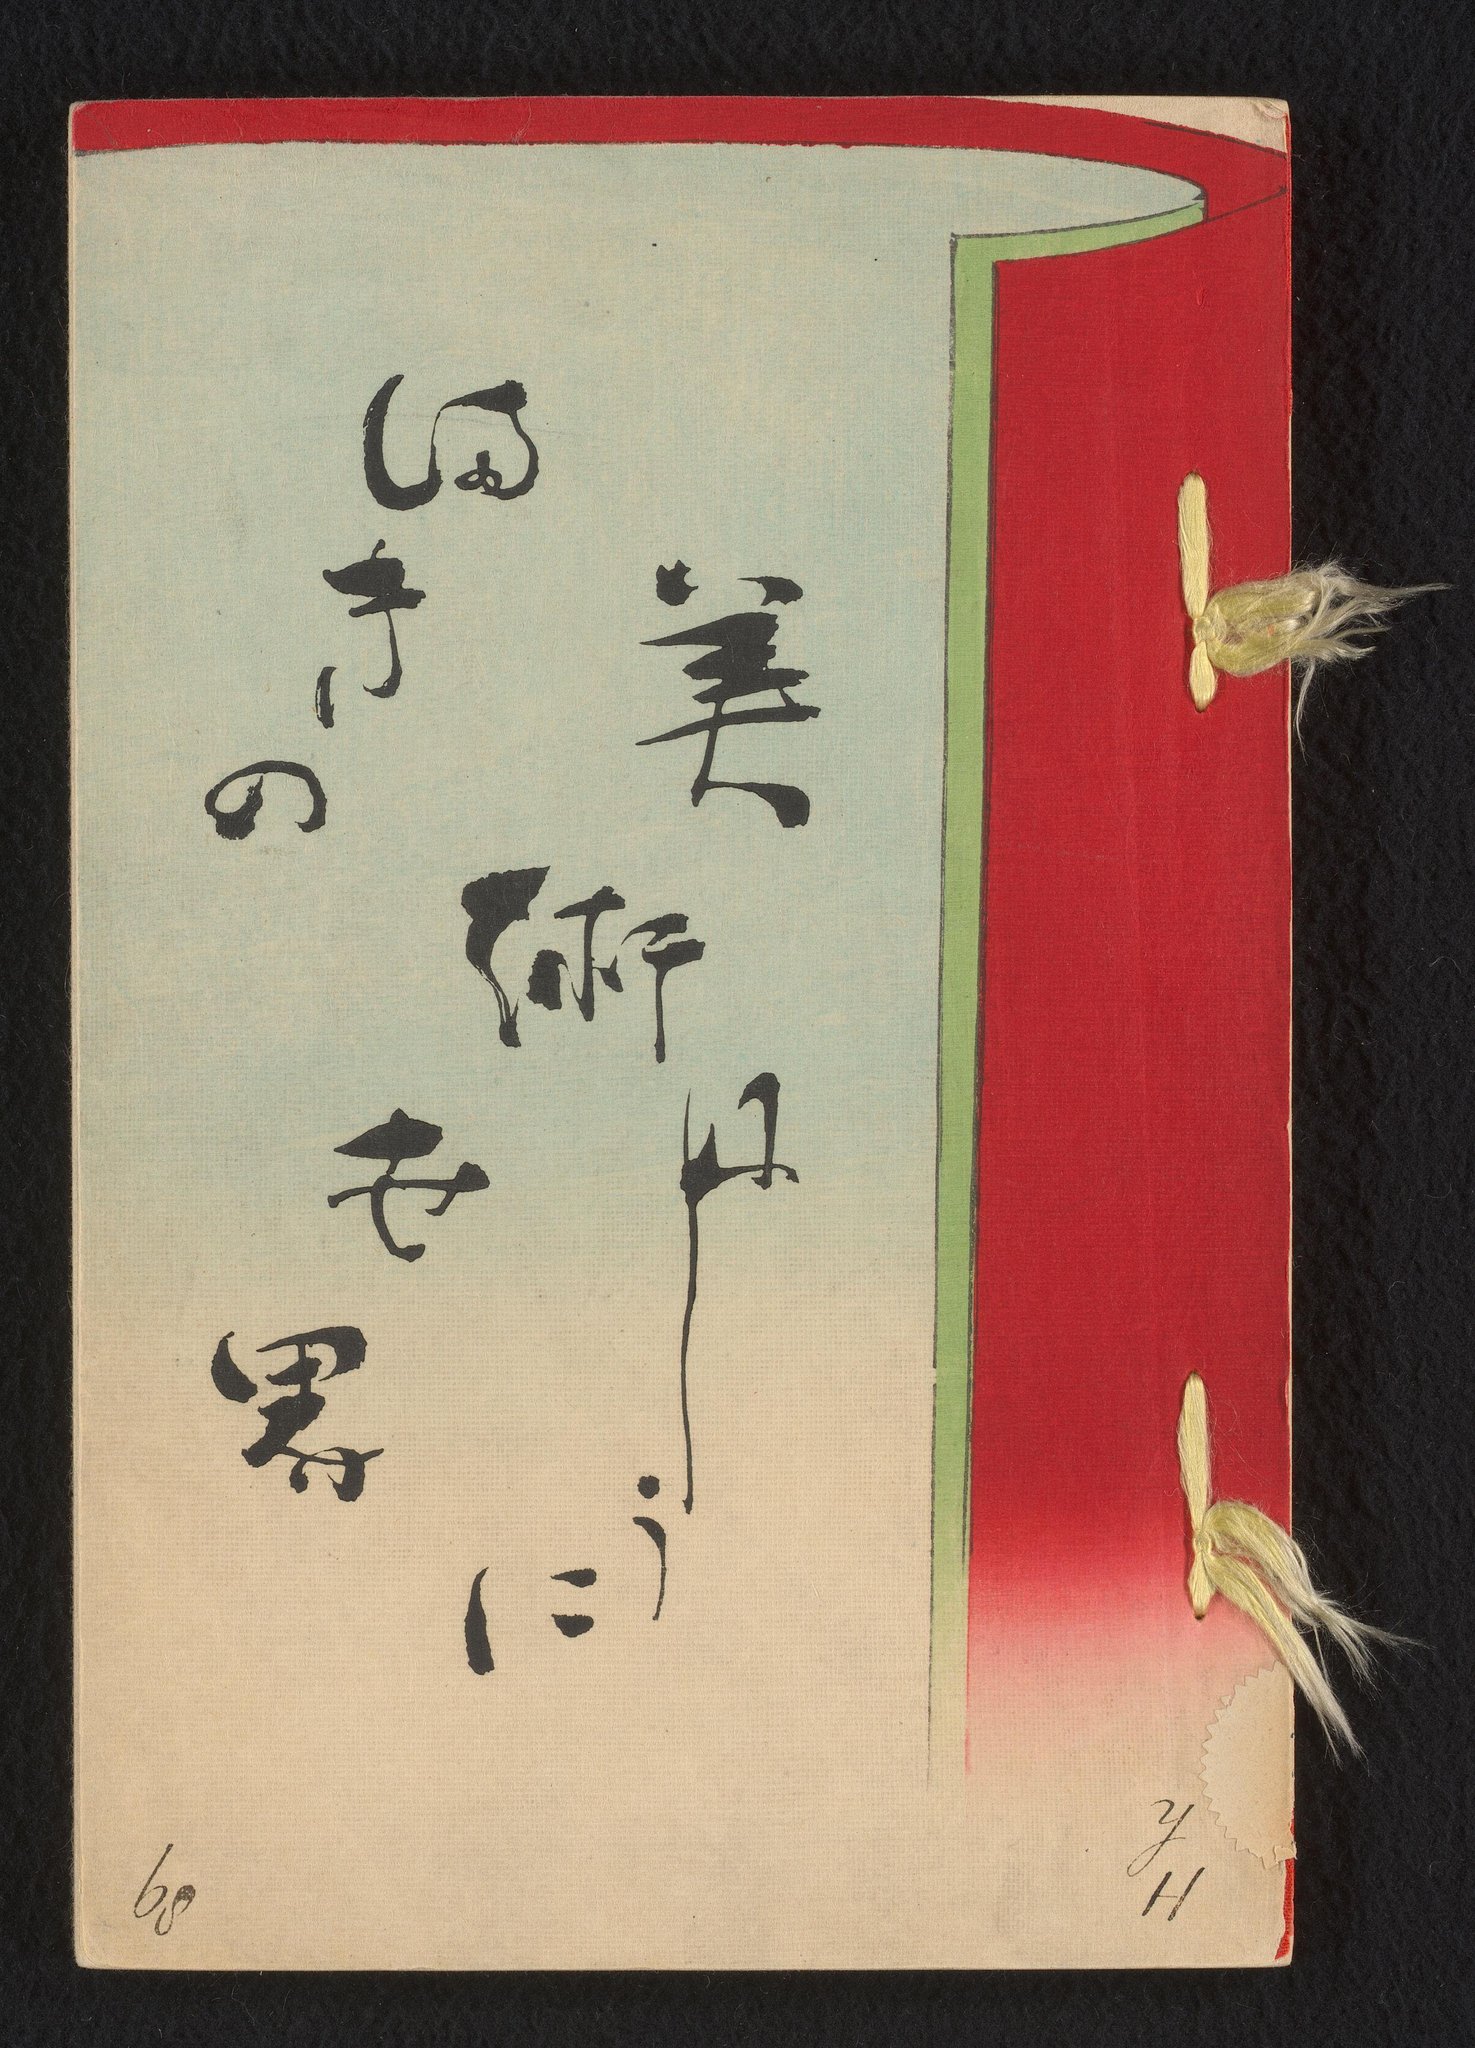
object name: book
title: Bijutsu sekai - 22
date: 1892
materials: paper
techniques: woodcut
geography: tokyo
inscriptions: collector's mark: ‘Rijksschool voor kunstnijverheid’ Lugt 3937